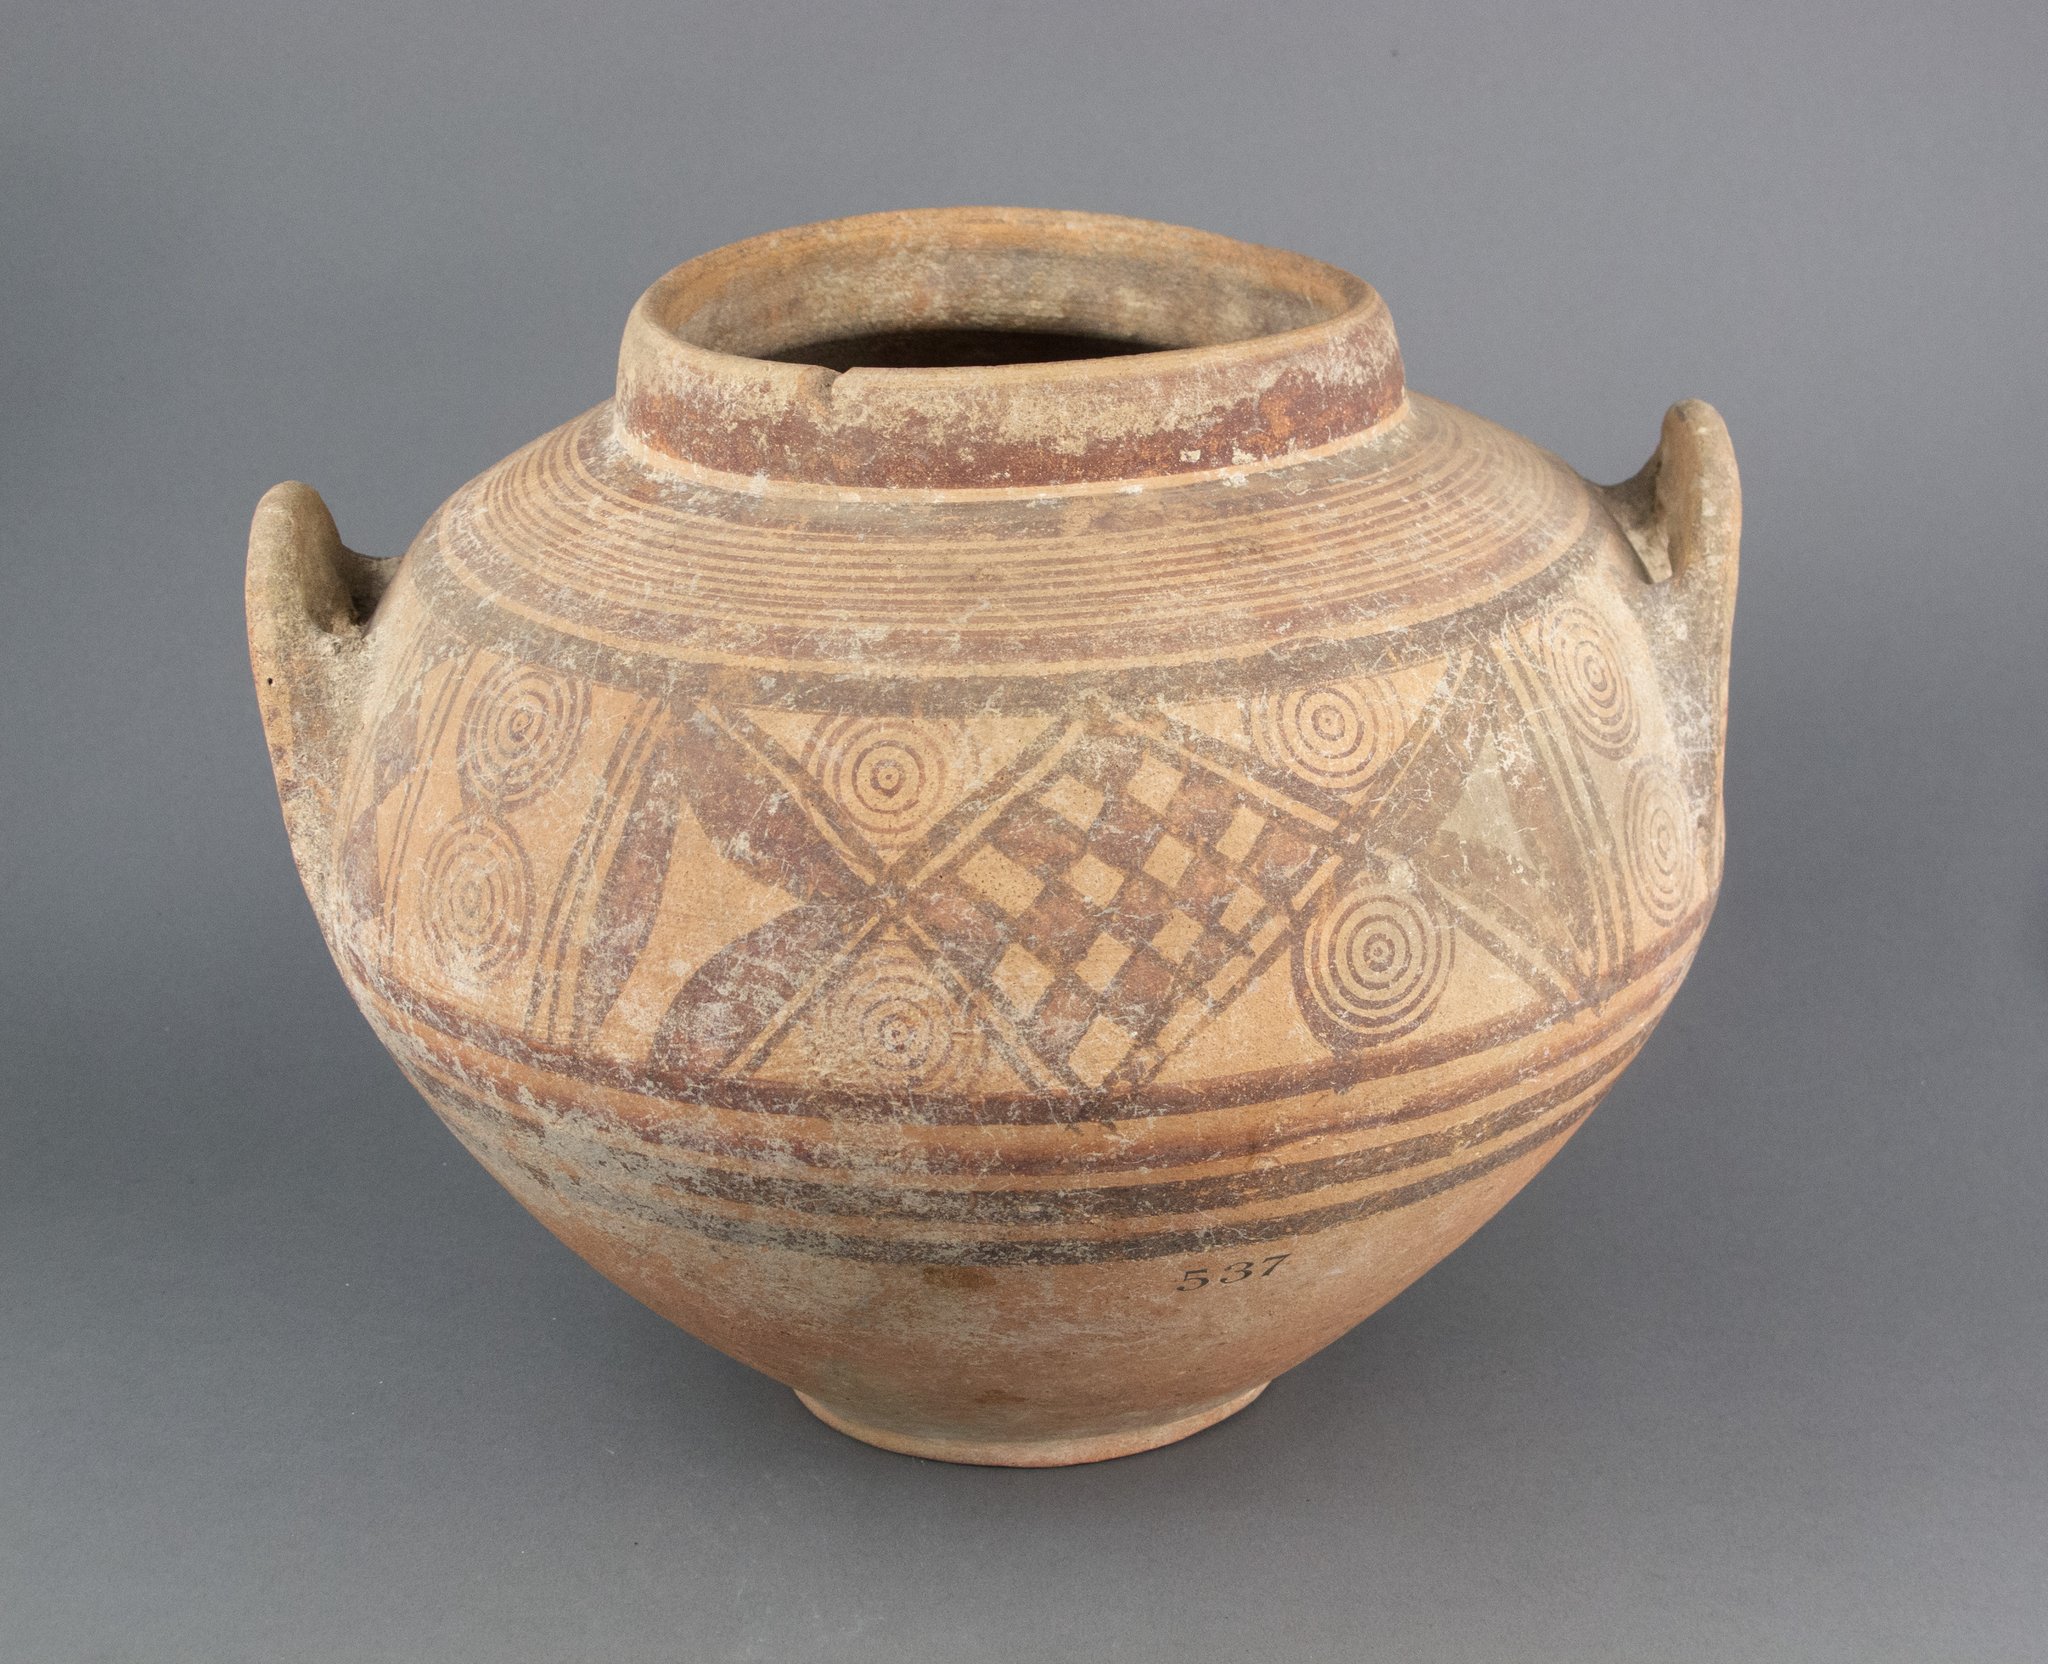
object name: amphora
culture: cypriot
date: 850-750 BCE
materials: terracotta